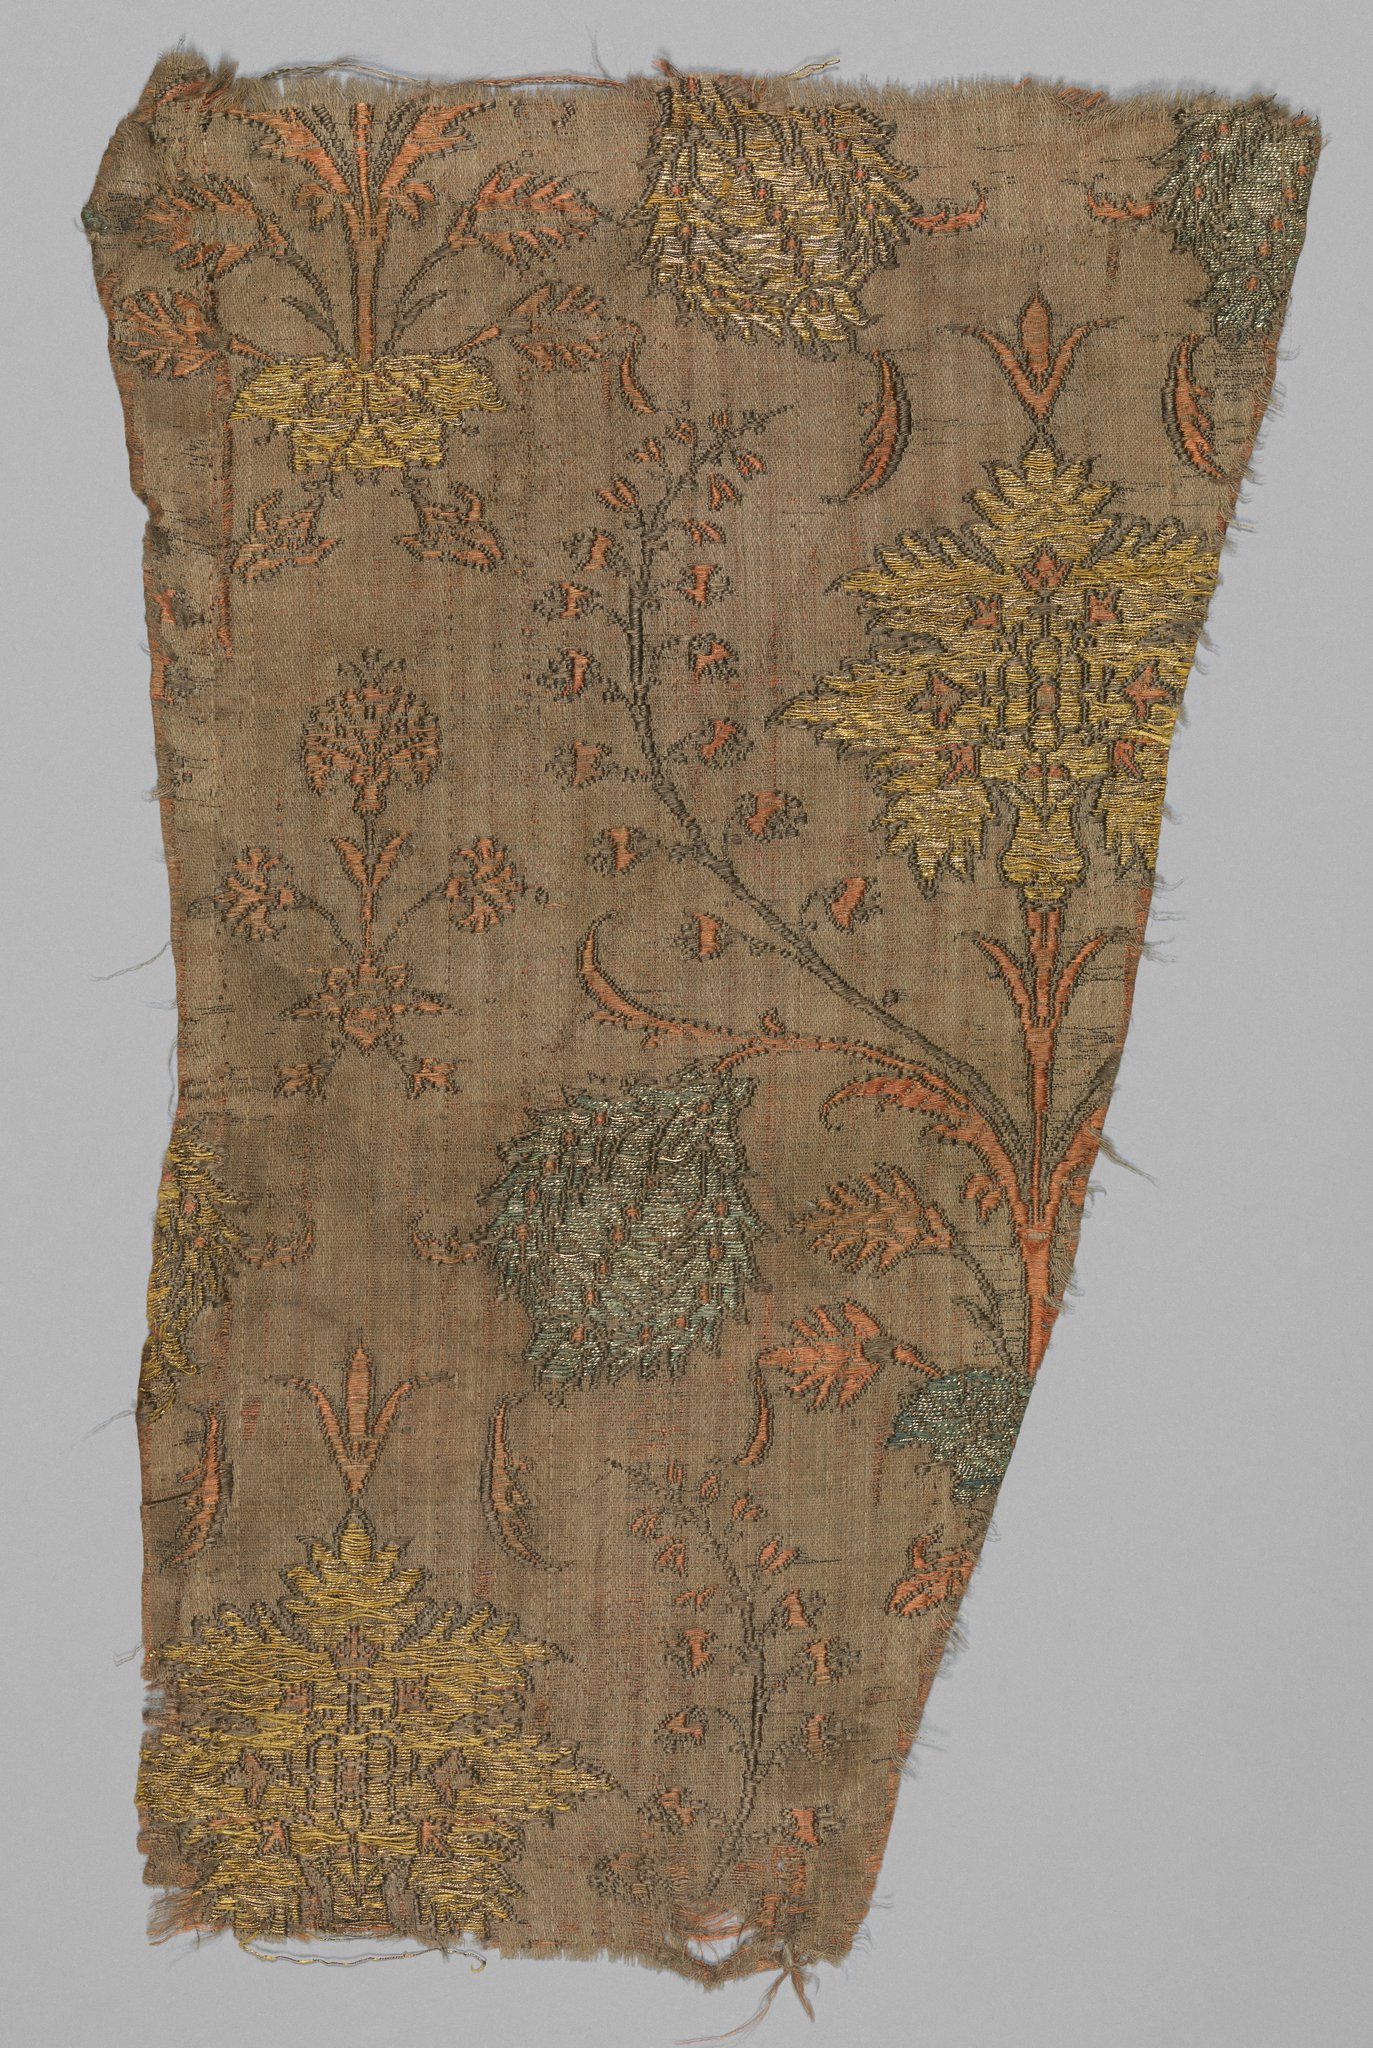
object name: textile fragment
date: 1667-1700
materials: metal, silk, thread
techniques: brocade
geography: iran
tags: leaves